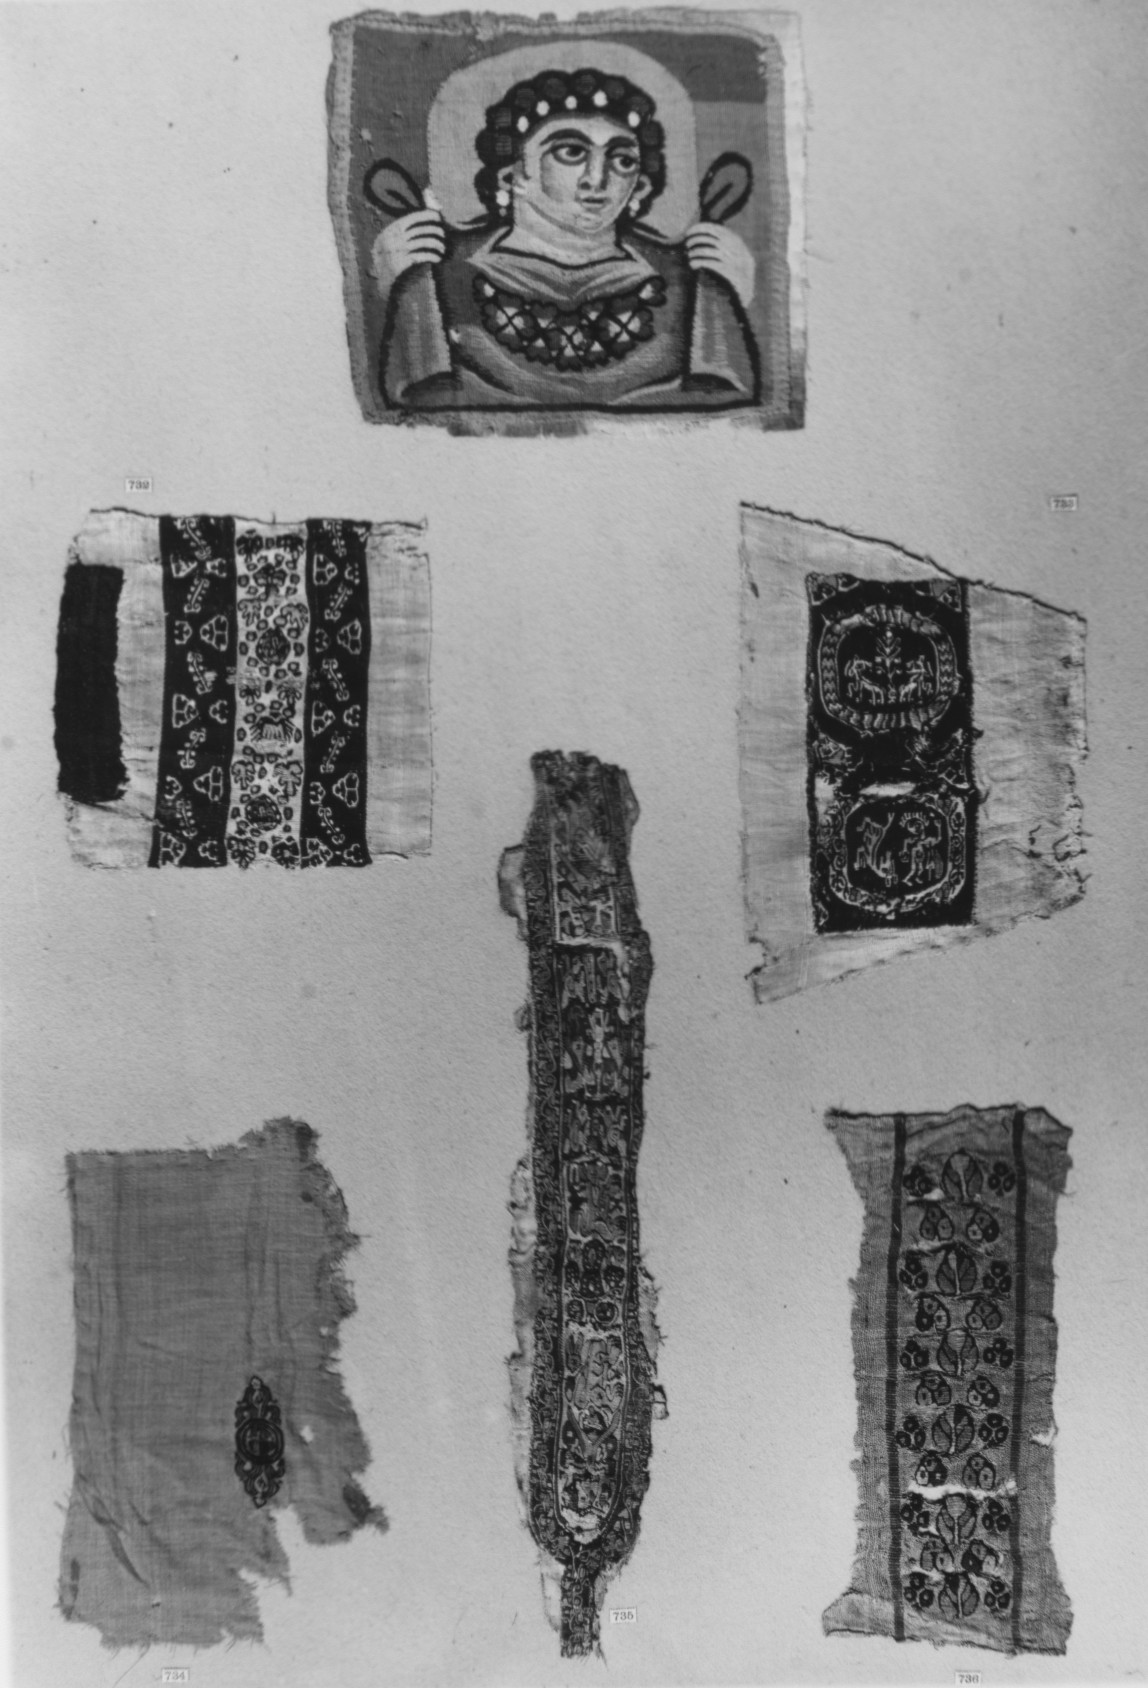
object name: textile fragment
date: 401-600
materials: linen, wool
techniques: weave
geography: egypt